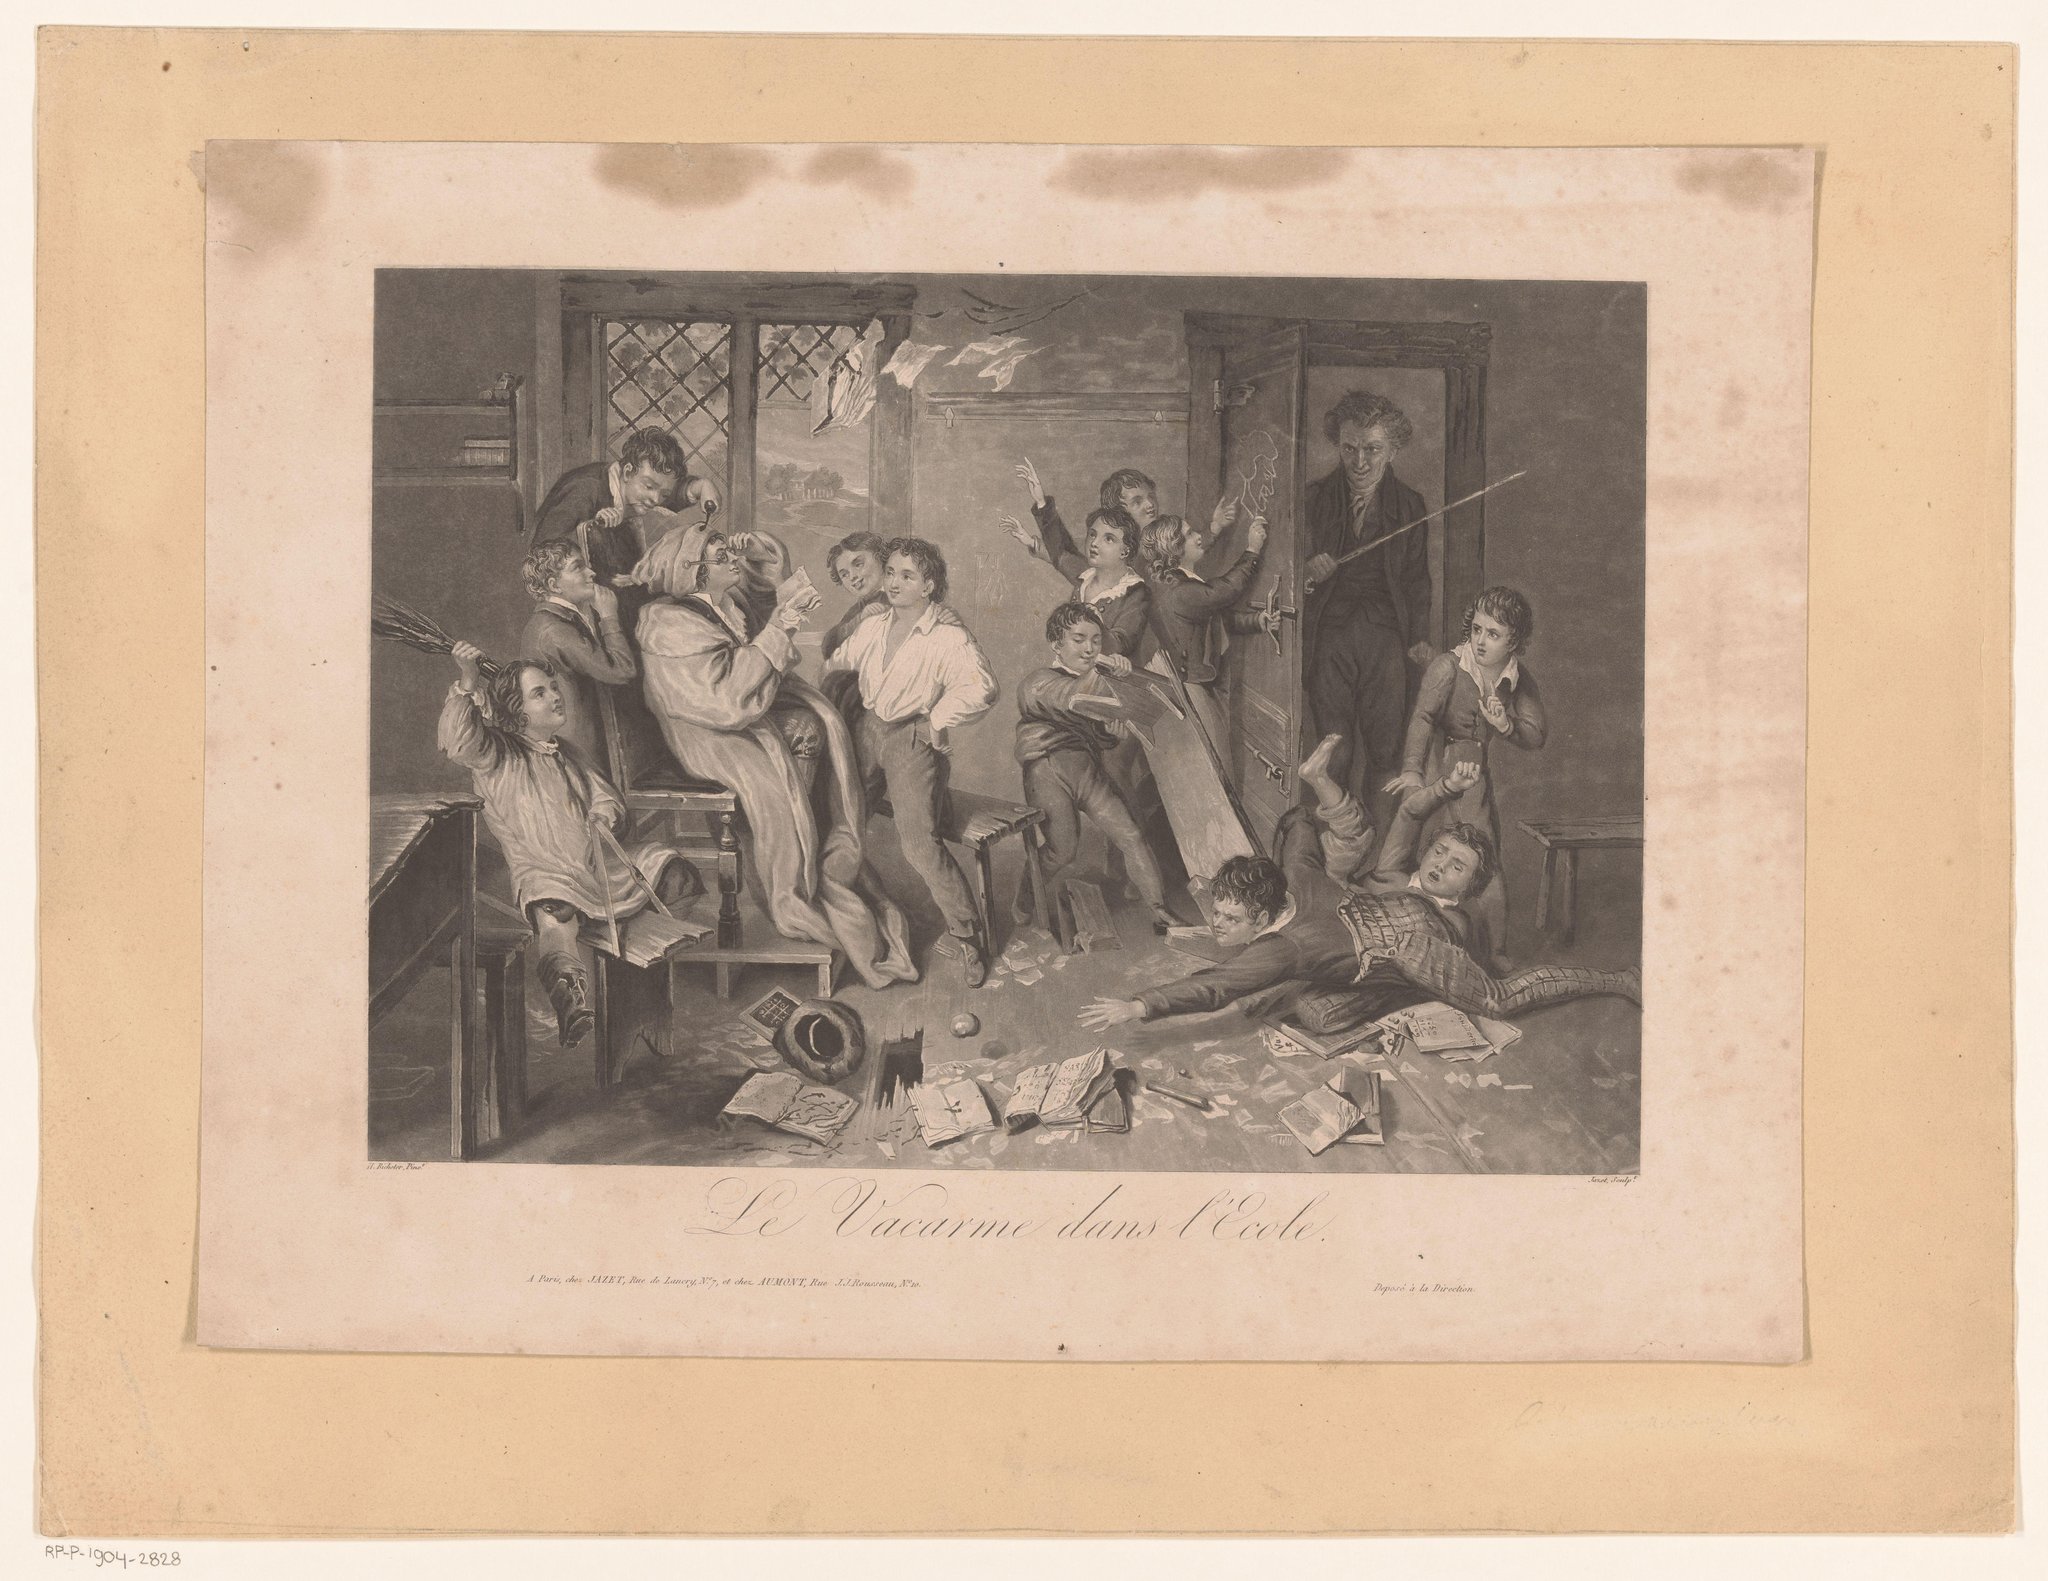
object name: print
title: Le vacarme dans l'Ecole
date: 1798-1871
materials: paper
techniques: etching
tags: teacher and pupil, mischievous child (at school)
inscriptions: collector's mark: Lugt 2228, : ‘Déposé à la Direction’